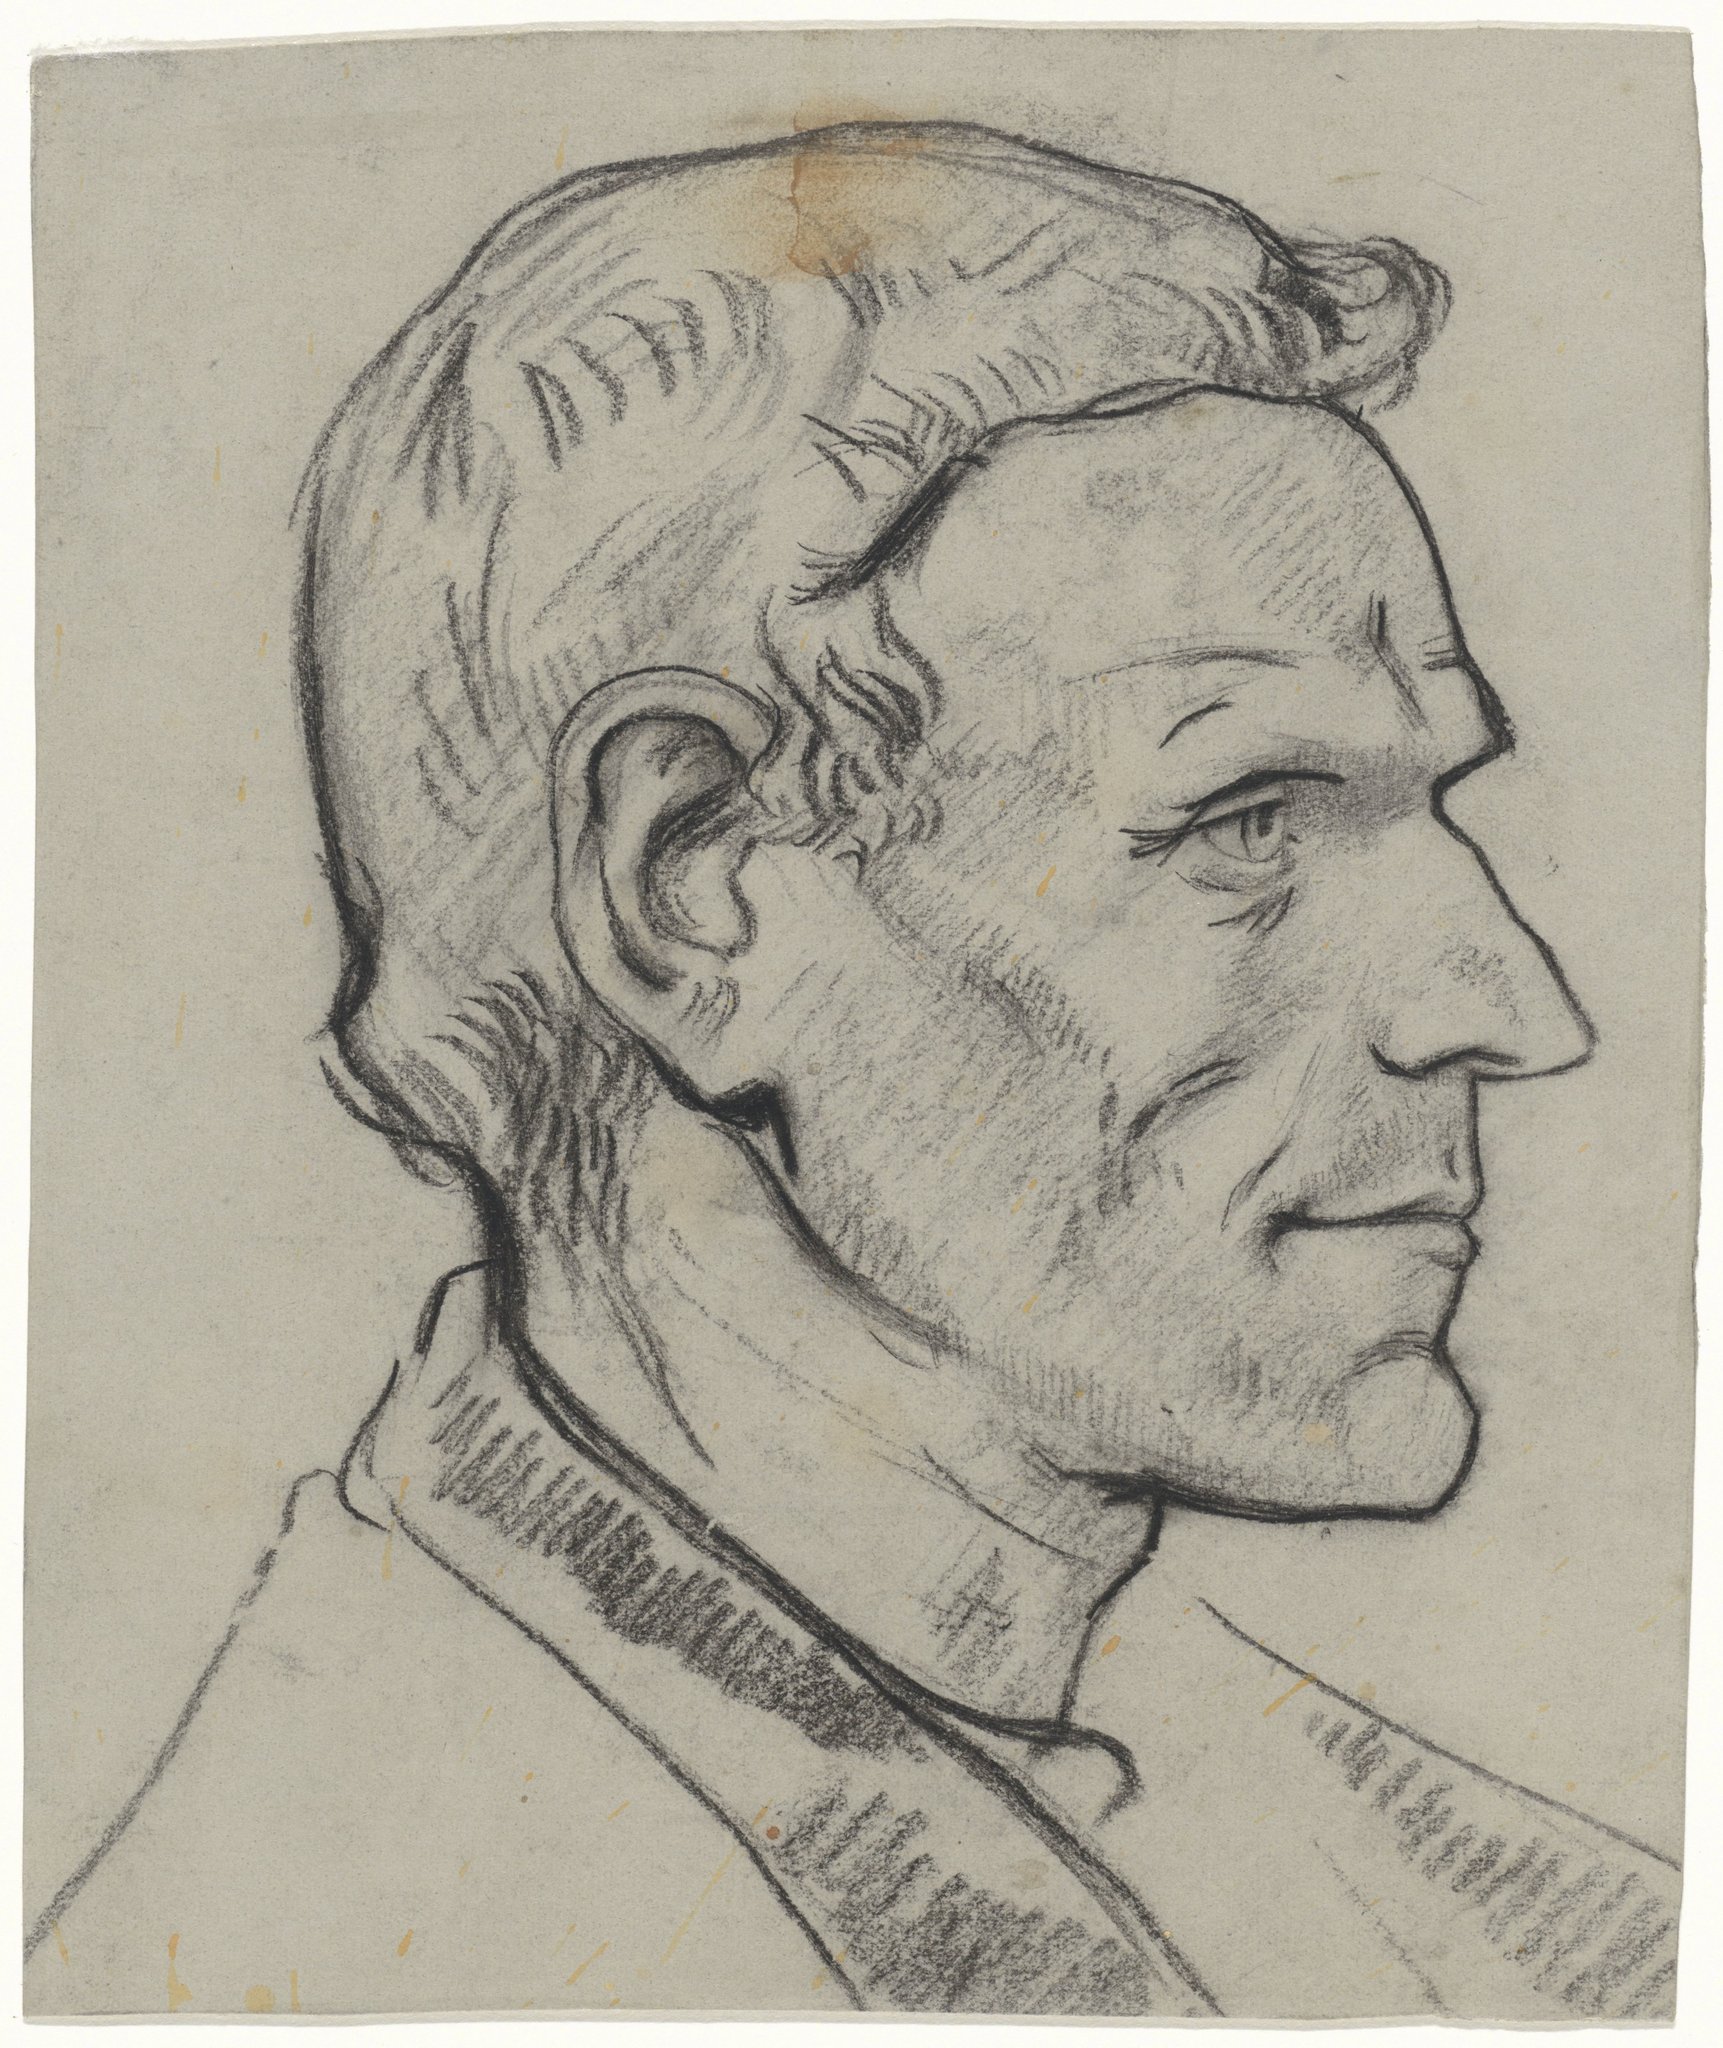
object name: drawing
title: Kop van een man, van opzij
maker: richard nicolaüs roland holst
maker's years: 1868-1938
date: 1878-1938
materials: chalk, paper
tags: anonymous historical person portrayed alone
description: Kop van een man, van opzij; op de verso een fragment van de litho Mélisande.